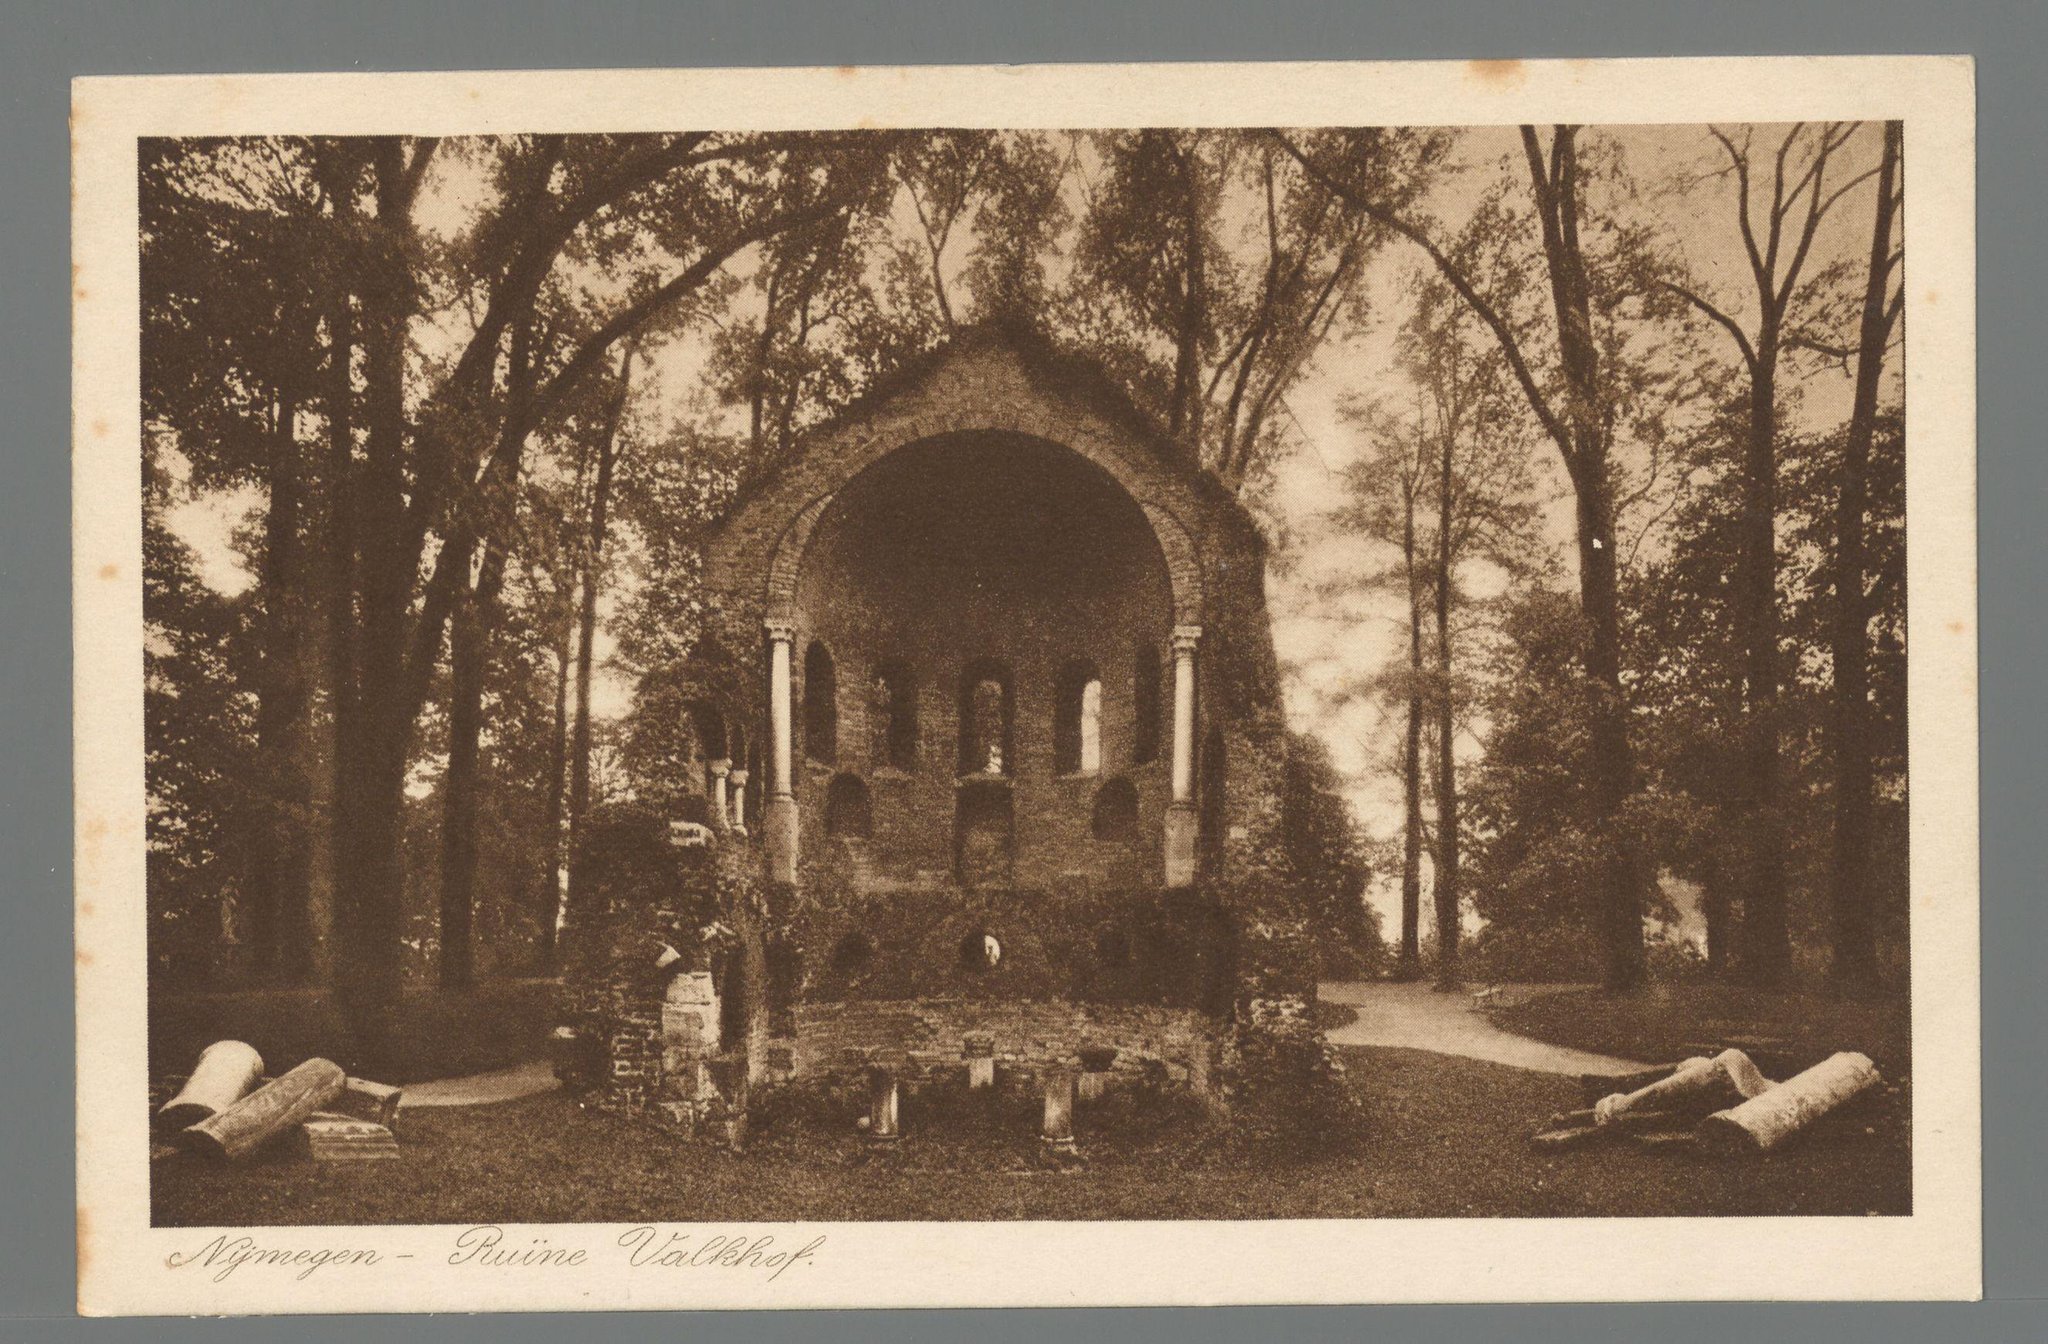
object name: photomechanical print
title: Nijmegen - Ruïne Valkhof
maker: Anonymous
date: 1918-1927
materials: cardboard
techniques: rotogravure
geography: nijmegen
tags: park, ruin of church, monastery, etc. - qq - small church, chapel, church (exterior) - qq - small church, chapel